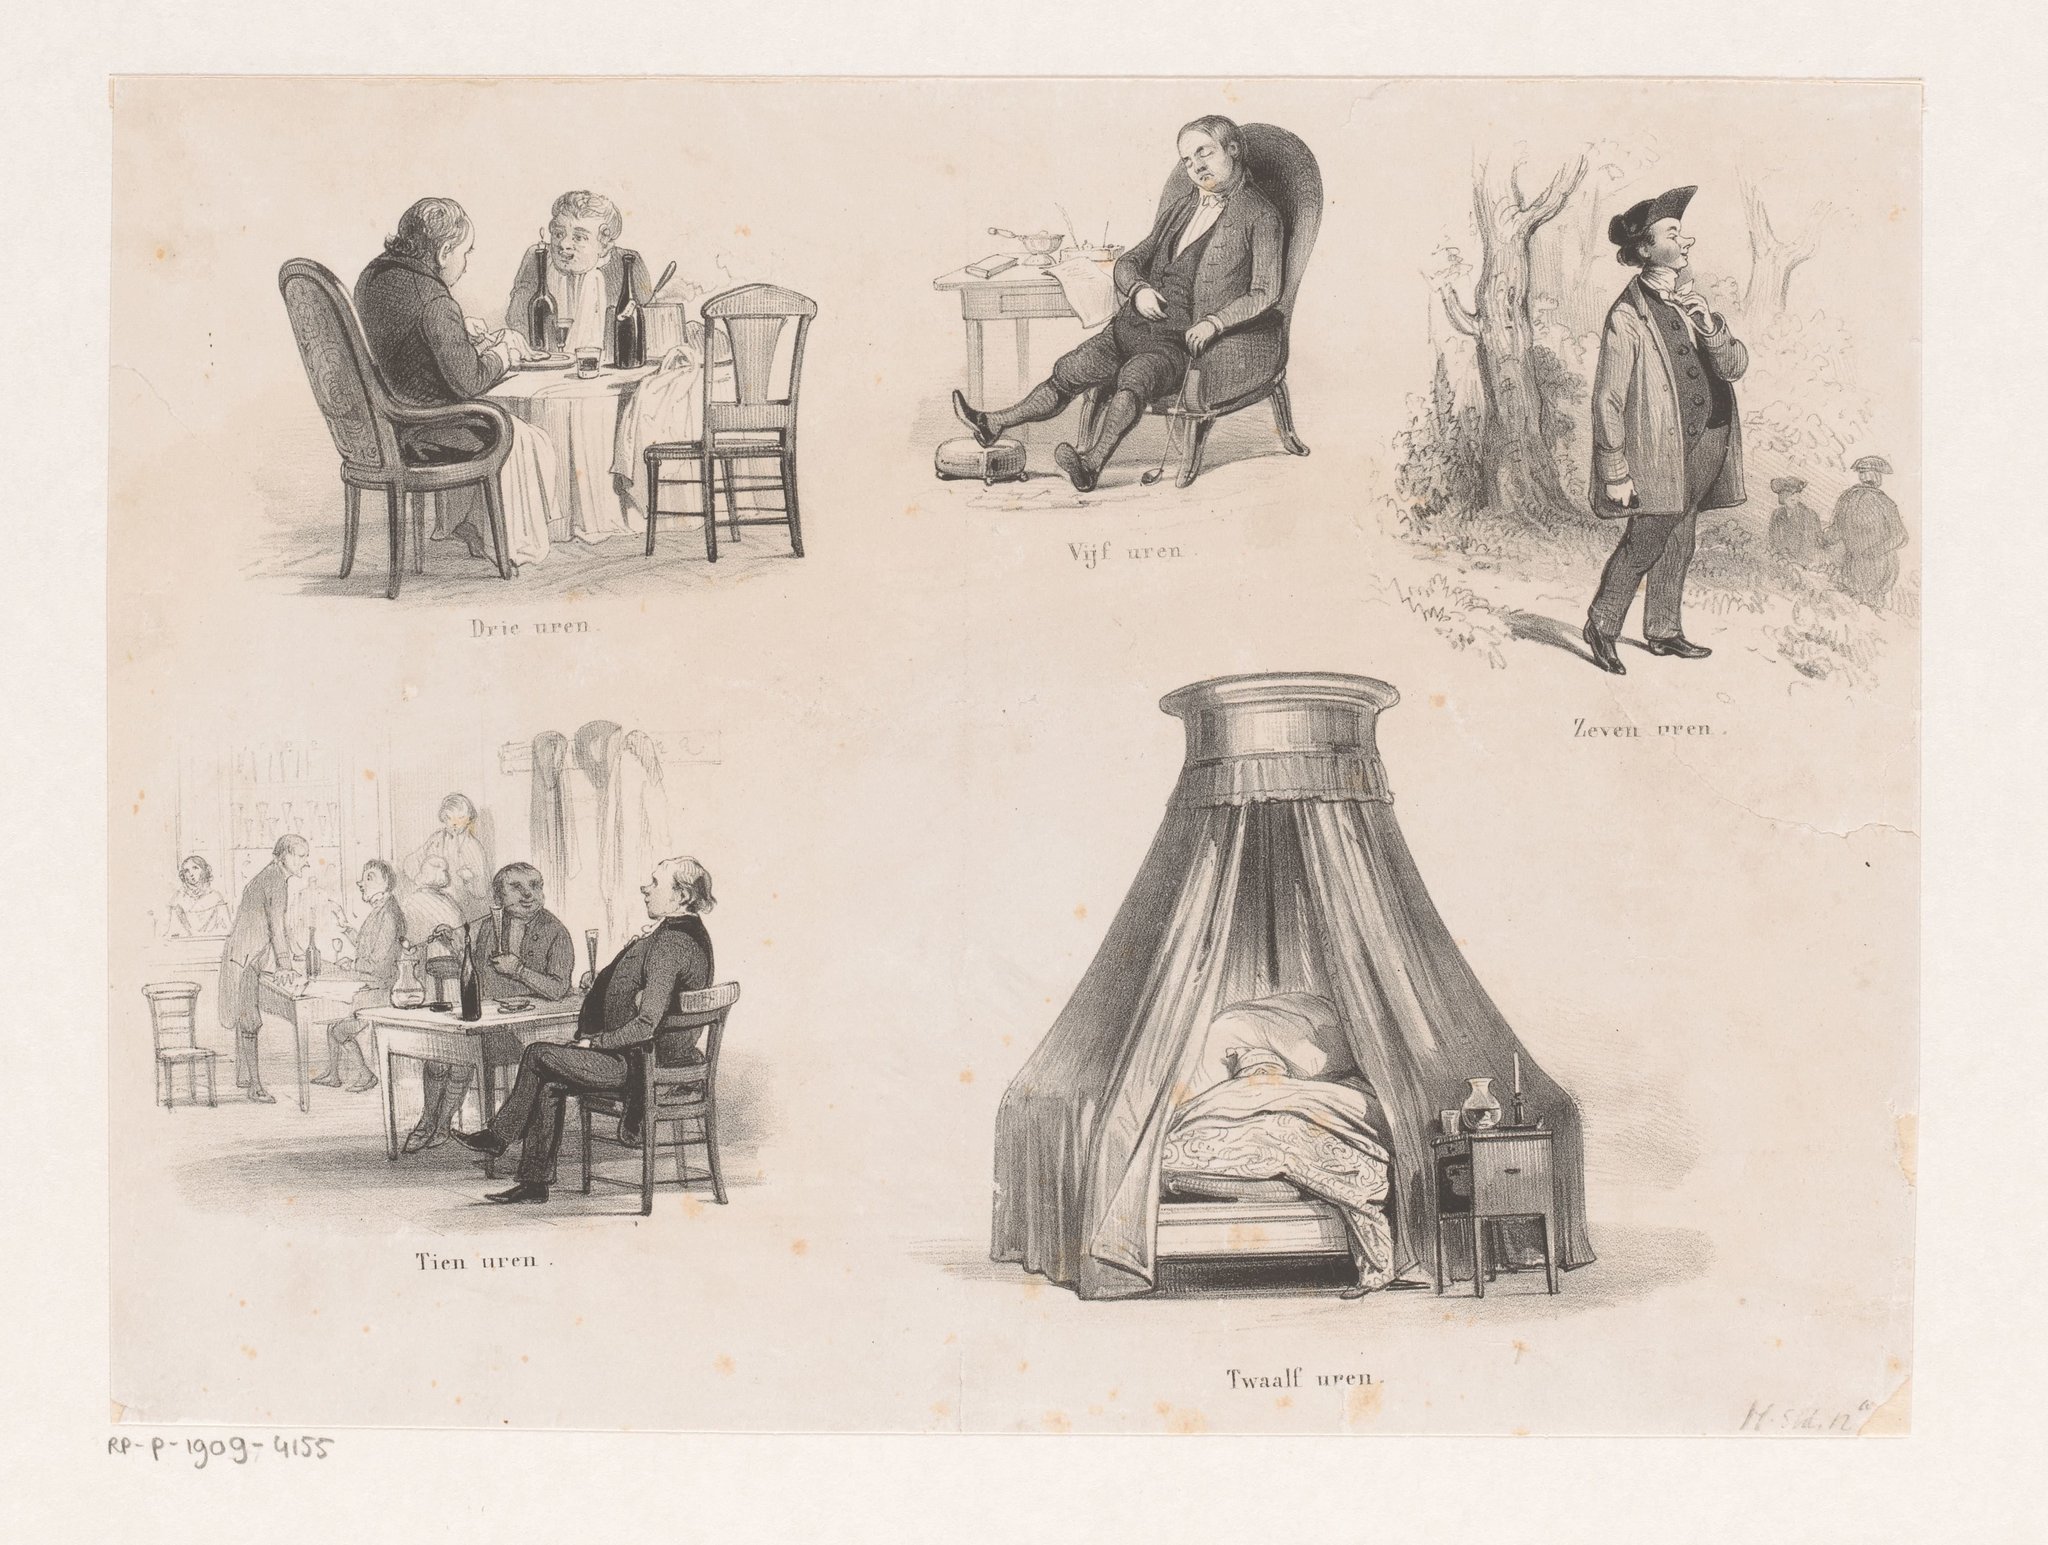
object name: print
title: Handelingen der Herv: Sijnode 1849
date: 1849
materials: paper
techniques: lithograph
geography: zaltbommel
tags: organizations, assemblies, etc. in protestant churches, amsterdam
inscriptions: collector's mark: Lugt 2228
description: Spotprent over de vergadering van de Algemene Synode van de Hervormde Kerk te Amsterdam op 4 juli 1849. Afgebeeld de werkzaamheden van de gedelegeerden op de synode tussen drie uur 's middags en twaalf uur 's avonds: eten, rusten, wandelen, borrelen, slapen.